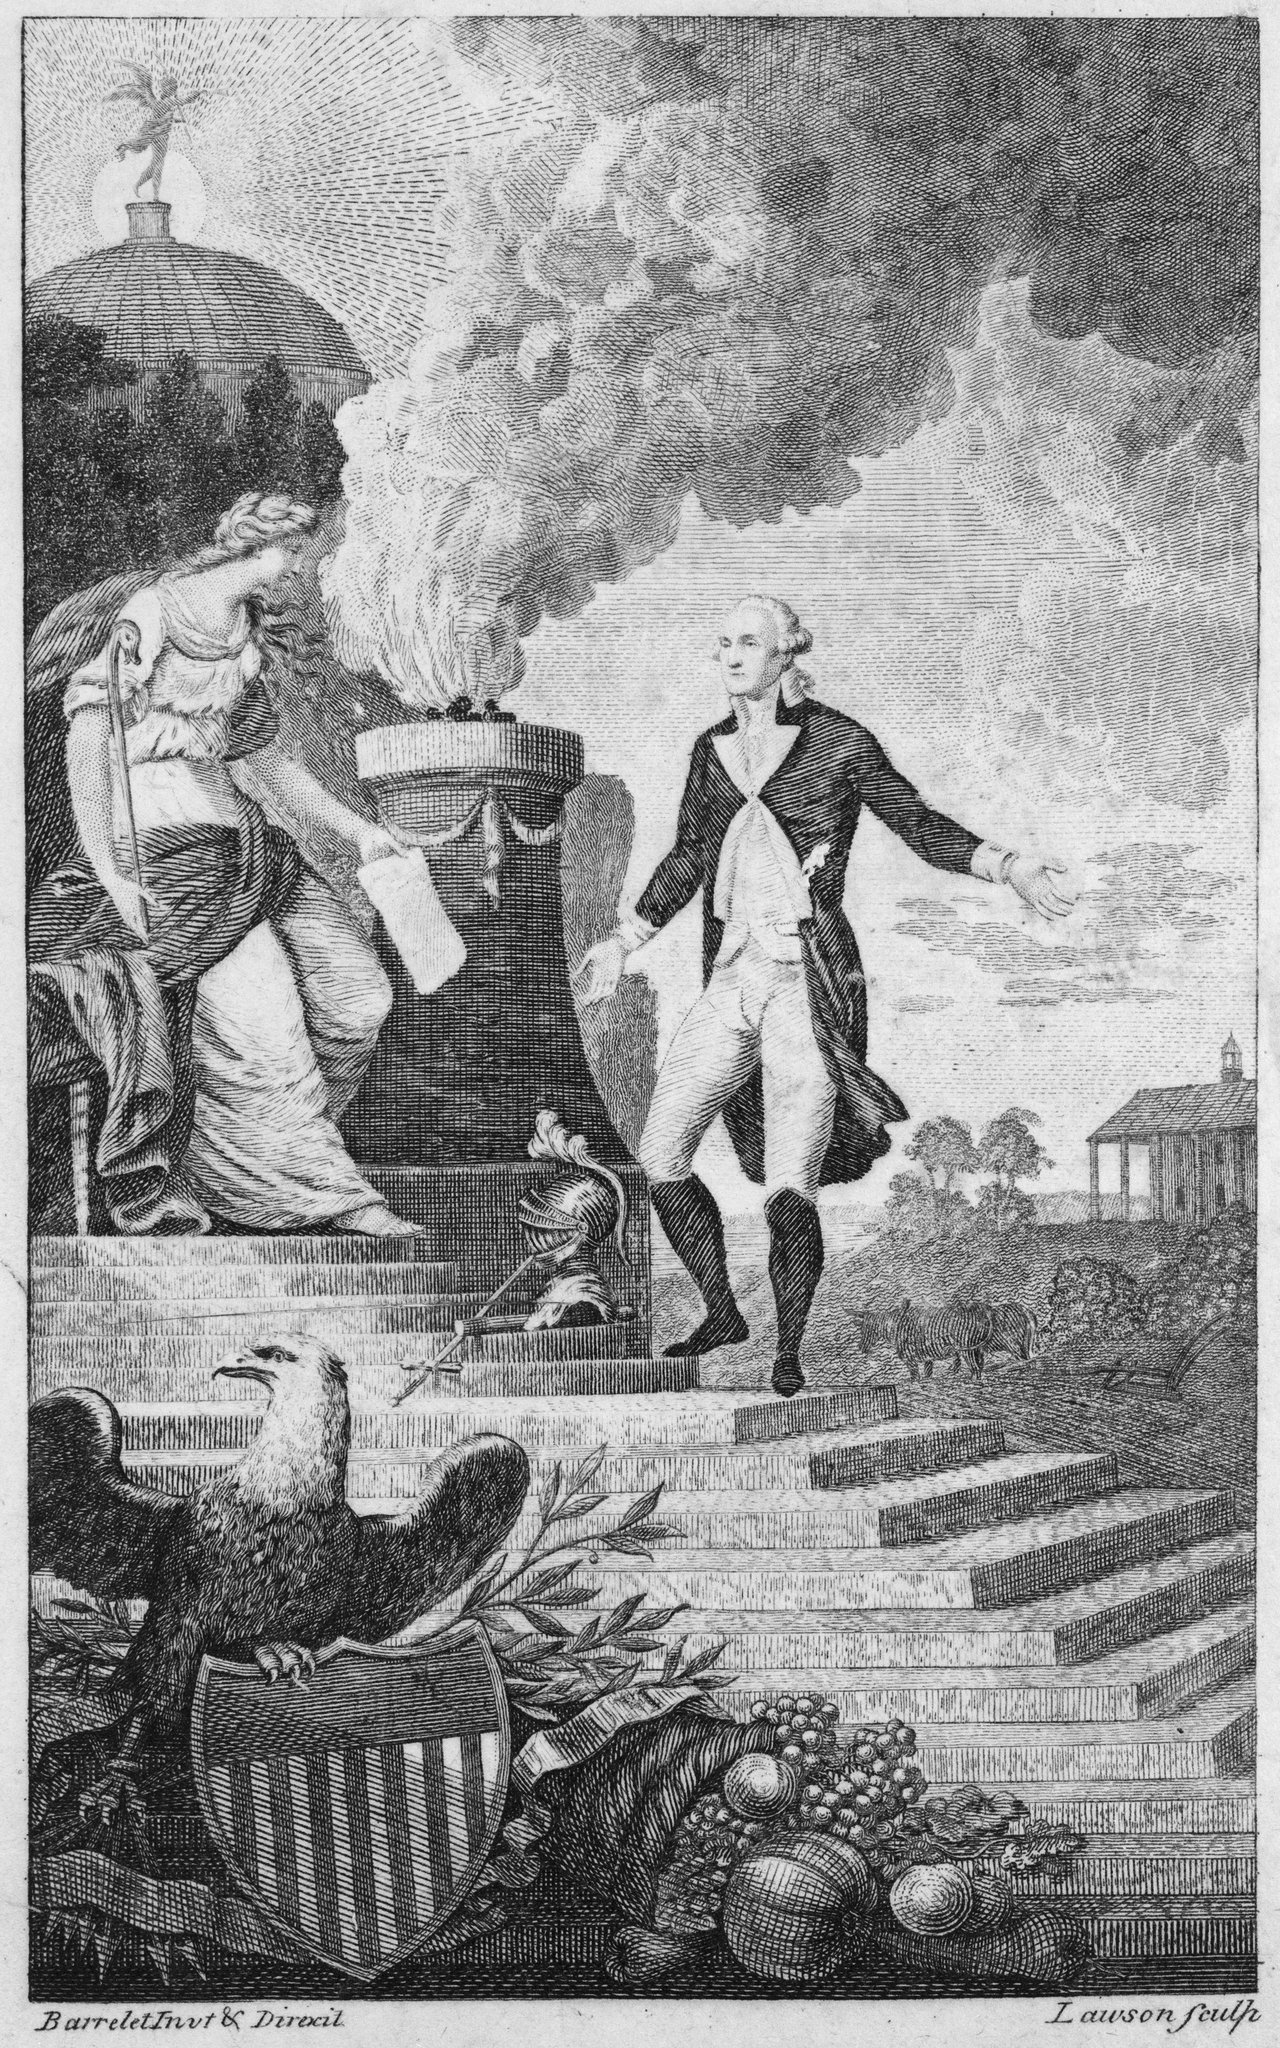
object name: print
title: General Washington's Resignation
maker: alexander lawson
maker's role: artist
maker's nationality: american, scottish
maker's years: 1773-1846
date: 1799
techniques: engraving, etching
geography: philadelphia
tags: eagles,george washington,women,coat of arms,generals